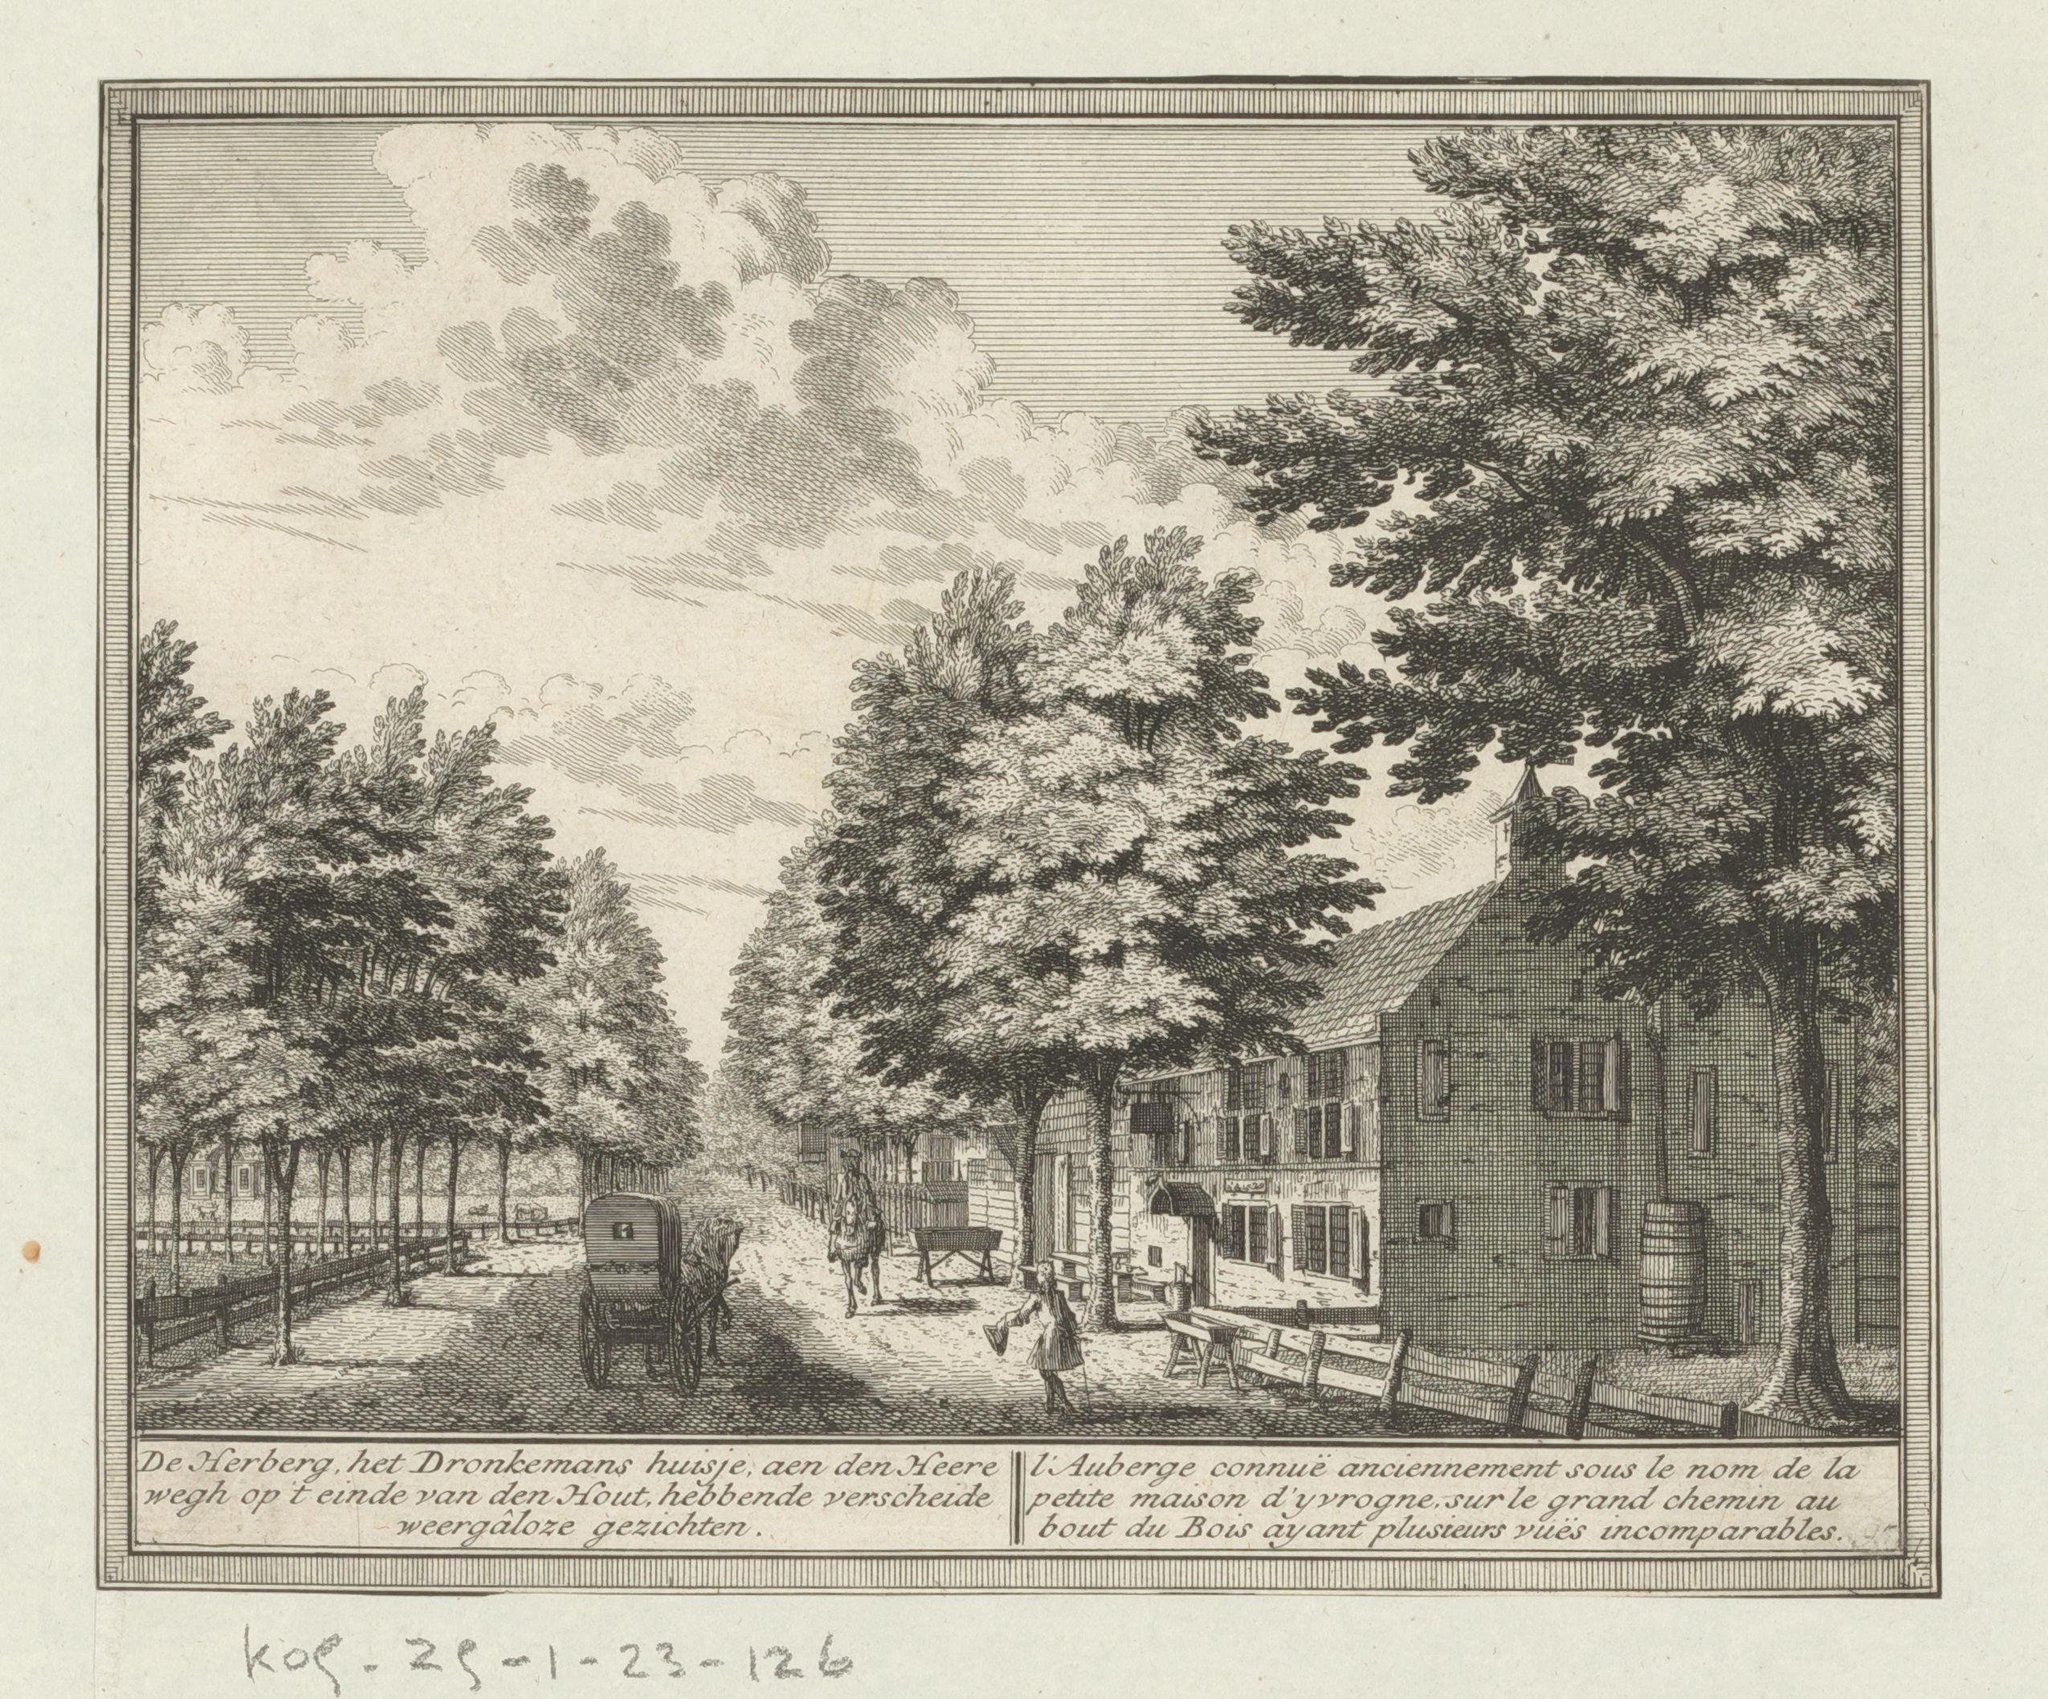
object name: print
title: De Herberg, het Dronkemans huisje, aen den Heere wegh op 't einde van den Hout, hebbende verscheide weergâloze gezichten / l'Auberge connuë anciennement sous le nom de la petite maison d'yvrogne, sur le grand chemin au bout du Bois ayant plusieurs vuës incomparables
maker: hendrik de leth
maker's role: draughtsman, print maker, publisher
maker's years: 1703-1766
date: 1732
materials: paper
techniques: engraving, etching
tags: animal traction, animal-drawn vehicle (carriage etc.), hotel, hostelry, inn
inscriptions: stamp, stamp, collector's mark: Lugt 1641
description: Prent waarschijnlijk uit: Broüerius van Nidek, Mattheus. Het Zegenpralent Kennemerlant, vertoont in veele Heerlijke Gezichten. Amsterdam: Leth, Hendrik de en Leth, Andries de, 1732, dl. 2.